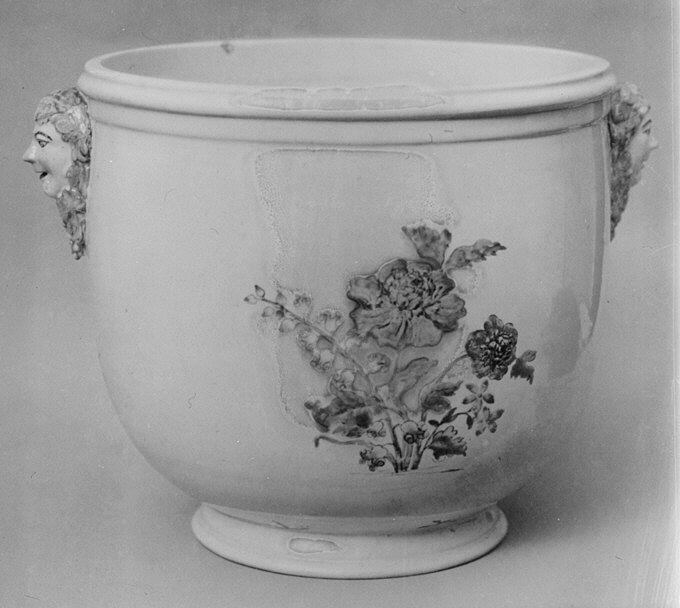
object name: bottle cooler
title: Bottle cooler (seau à bouteille)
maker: chantilly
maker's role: factory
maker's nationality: french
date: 1750-1755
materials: soft paste porcelain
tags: faces,flowers